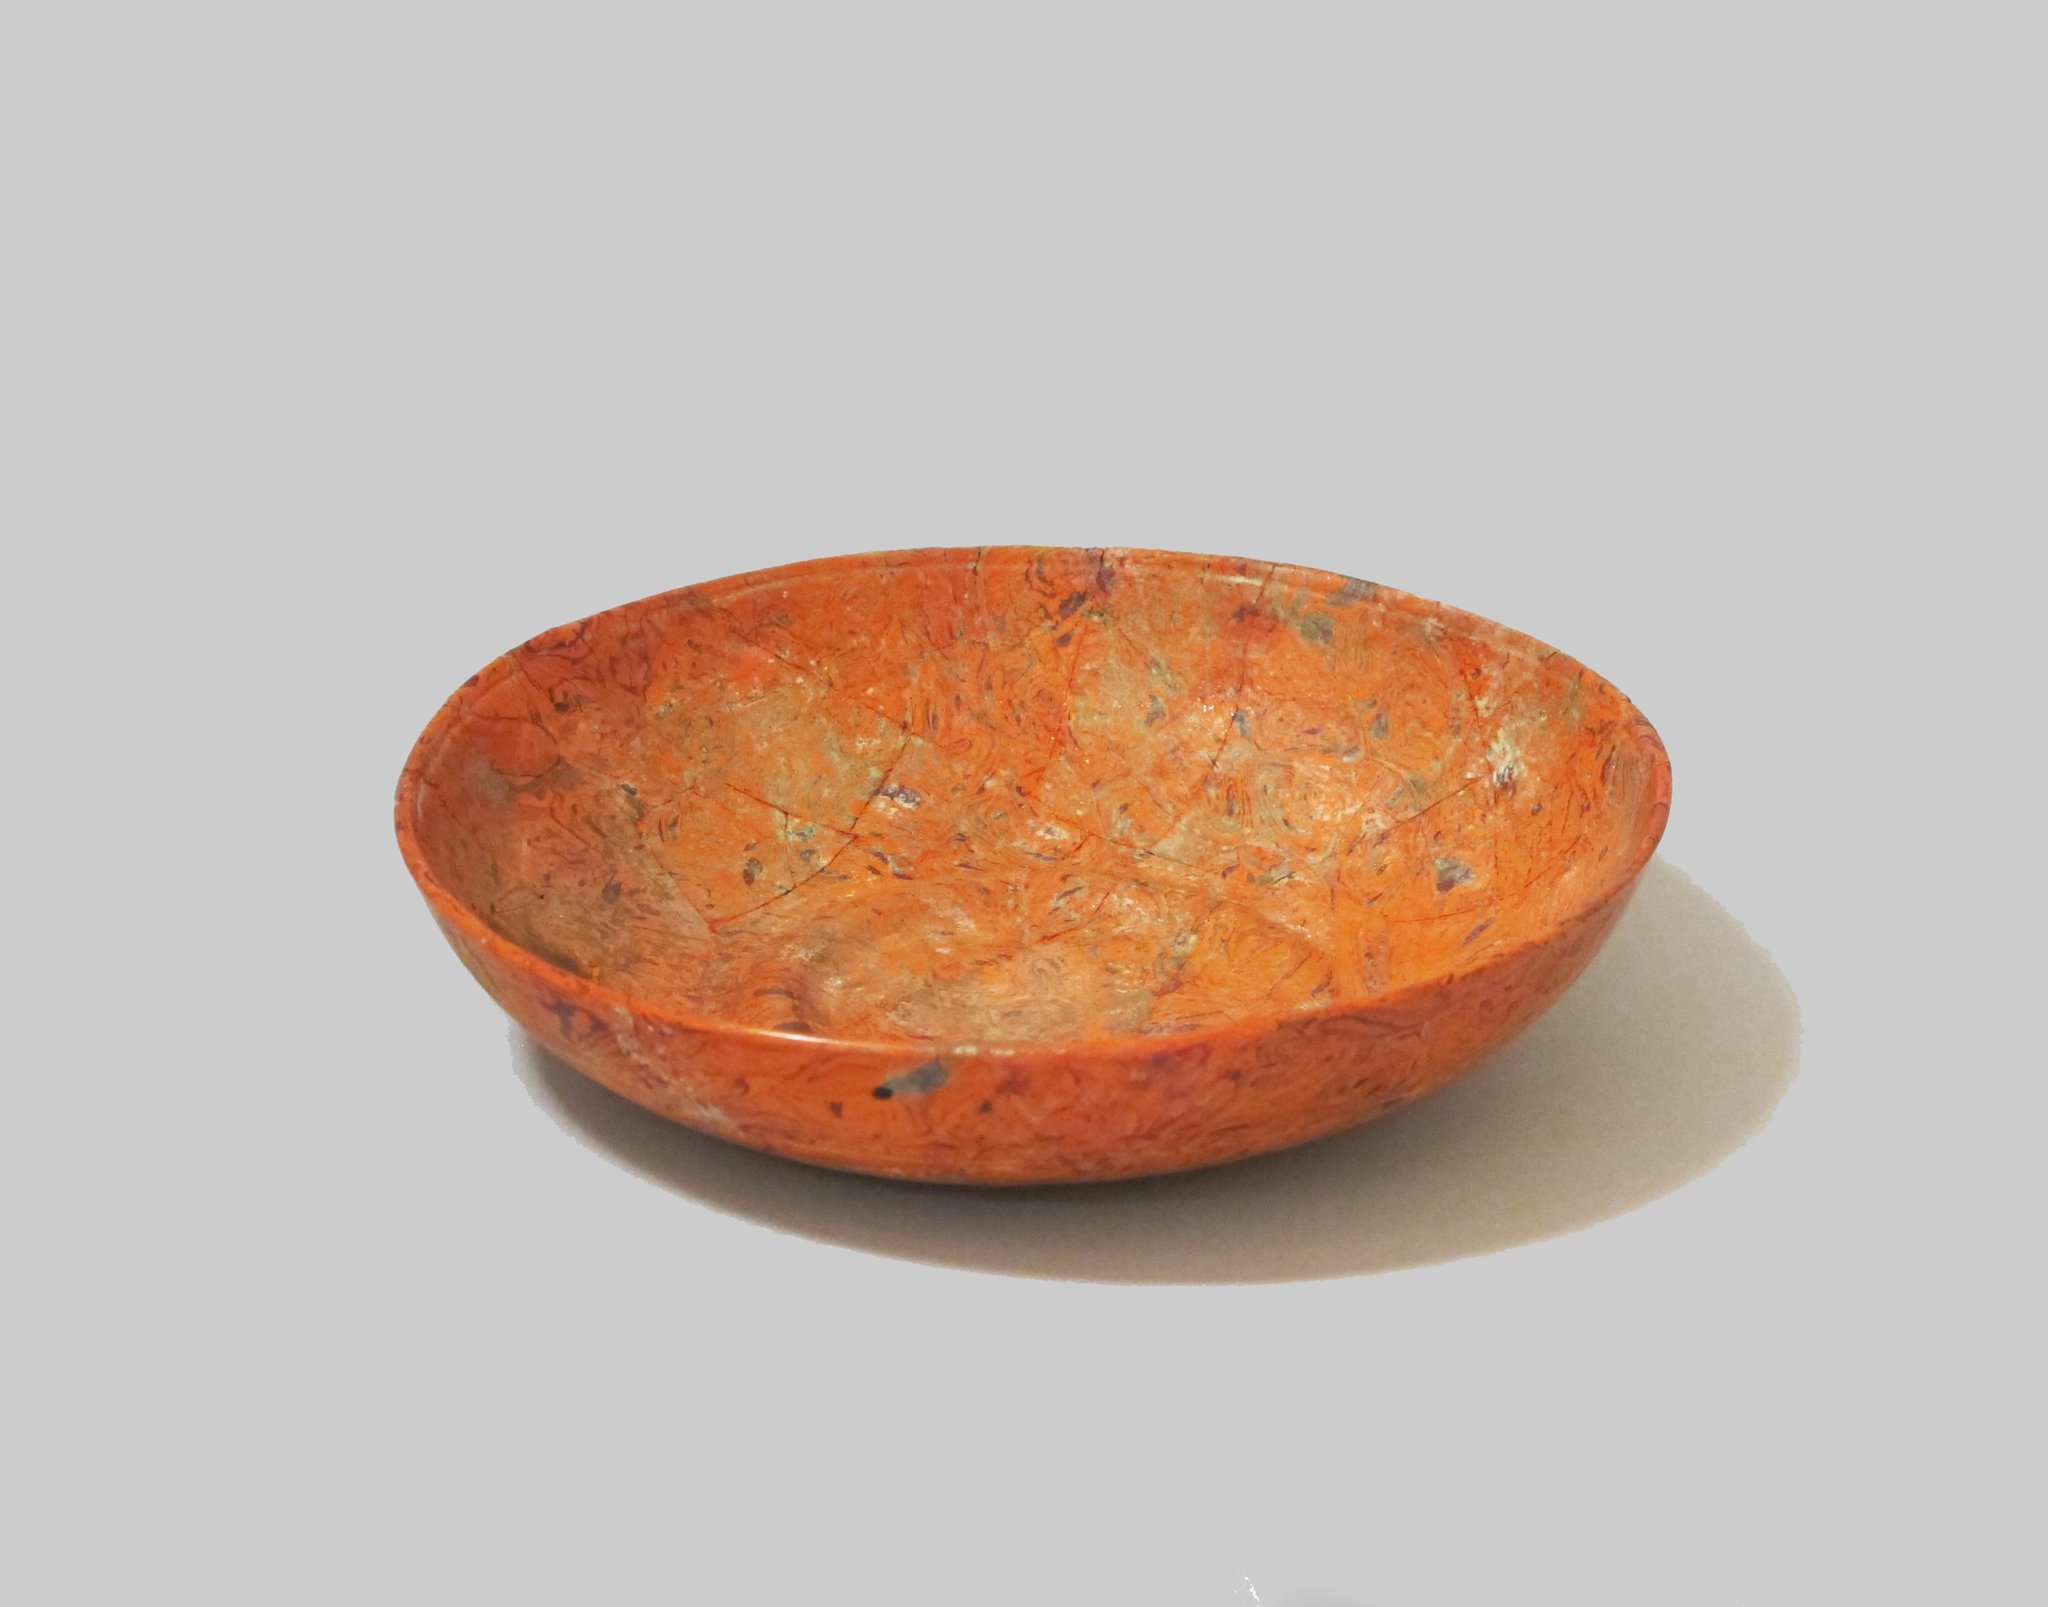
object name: bowl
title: Glass mosaic bowl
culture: roman, eastern mediterranean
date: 1-50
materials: glass